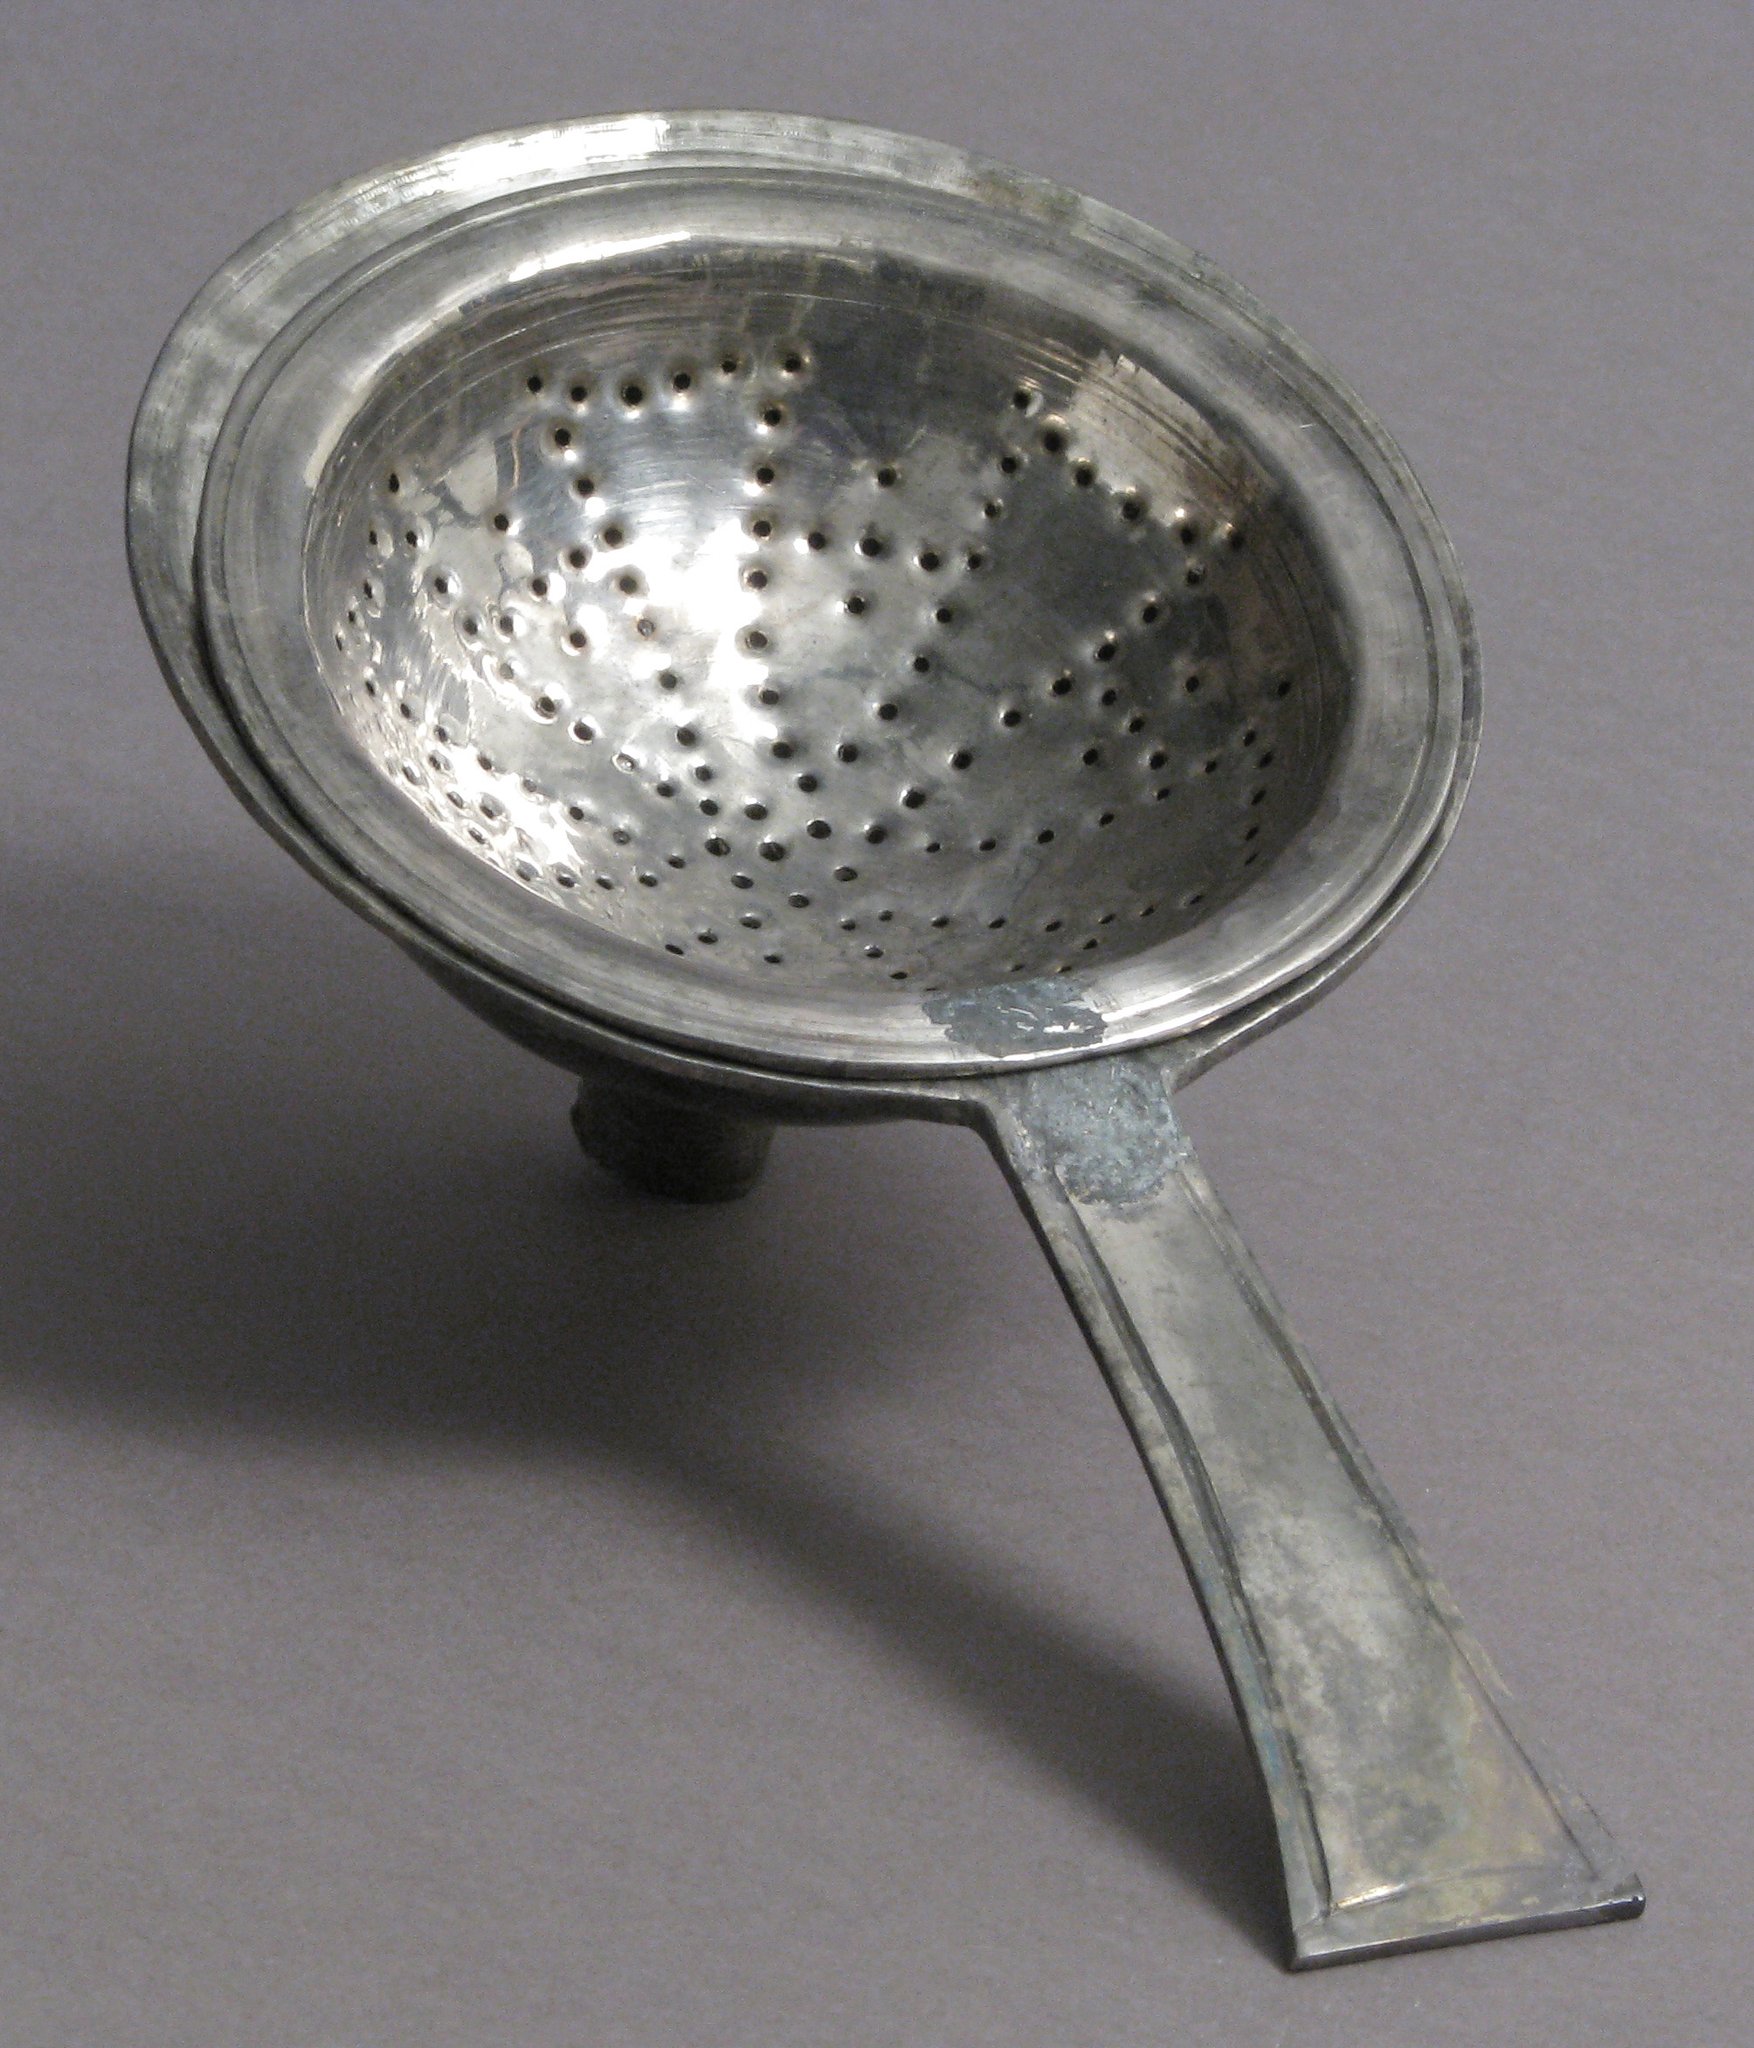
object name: strainer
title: The Attarouthi Treasure - Wine Strainer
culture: byzantine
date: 500-650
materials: silver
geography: syria